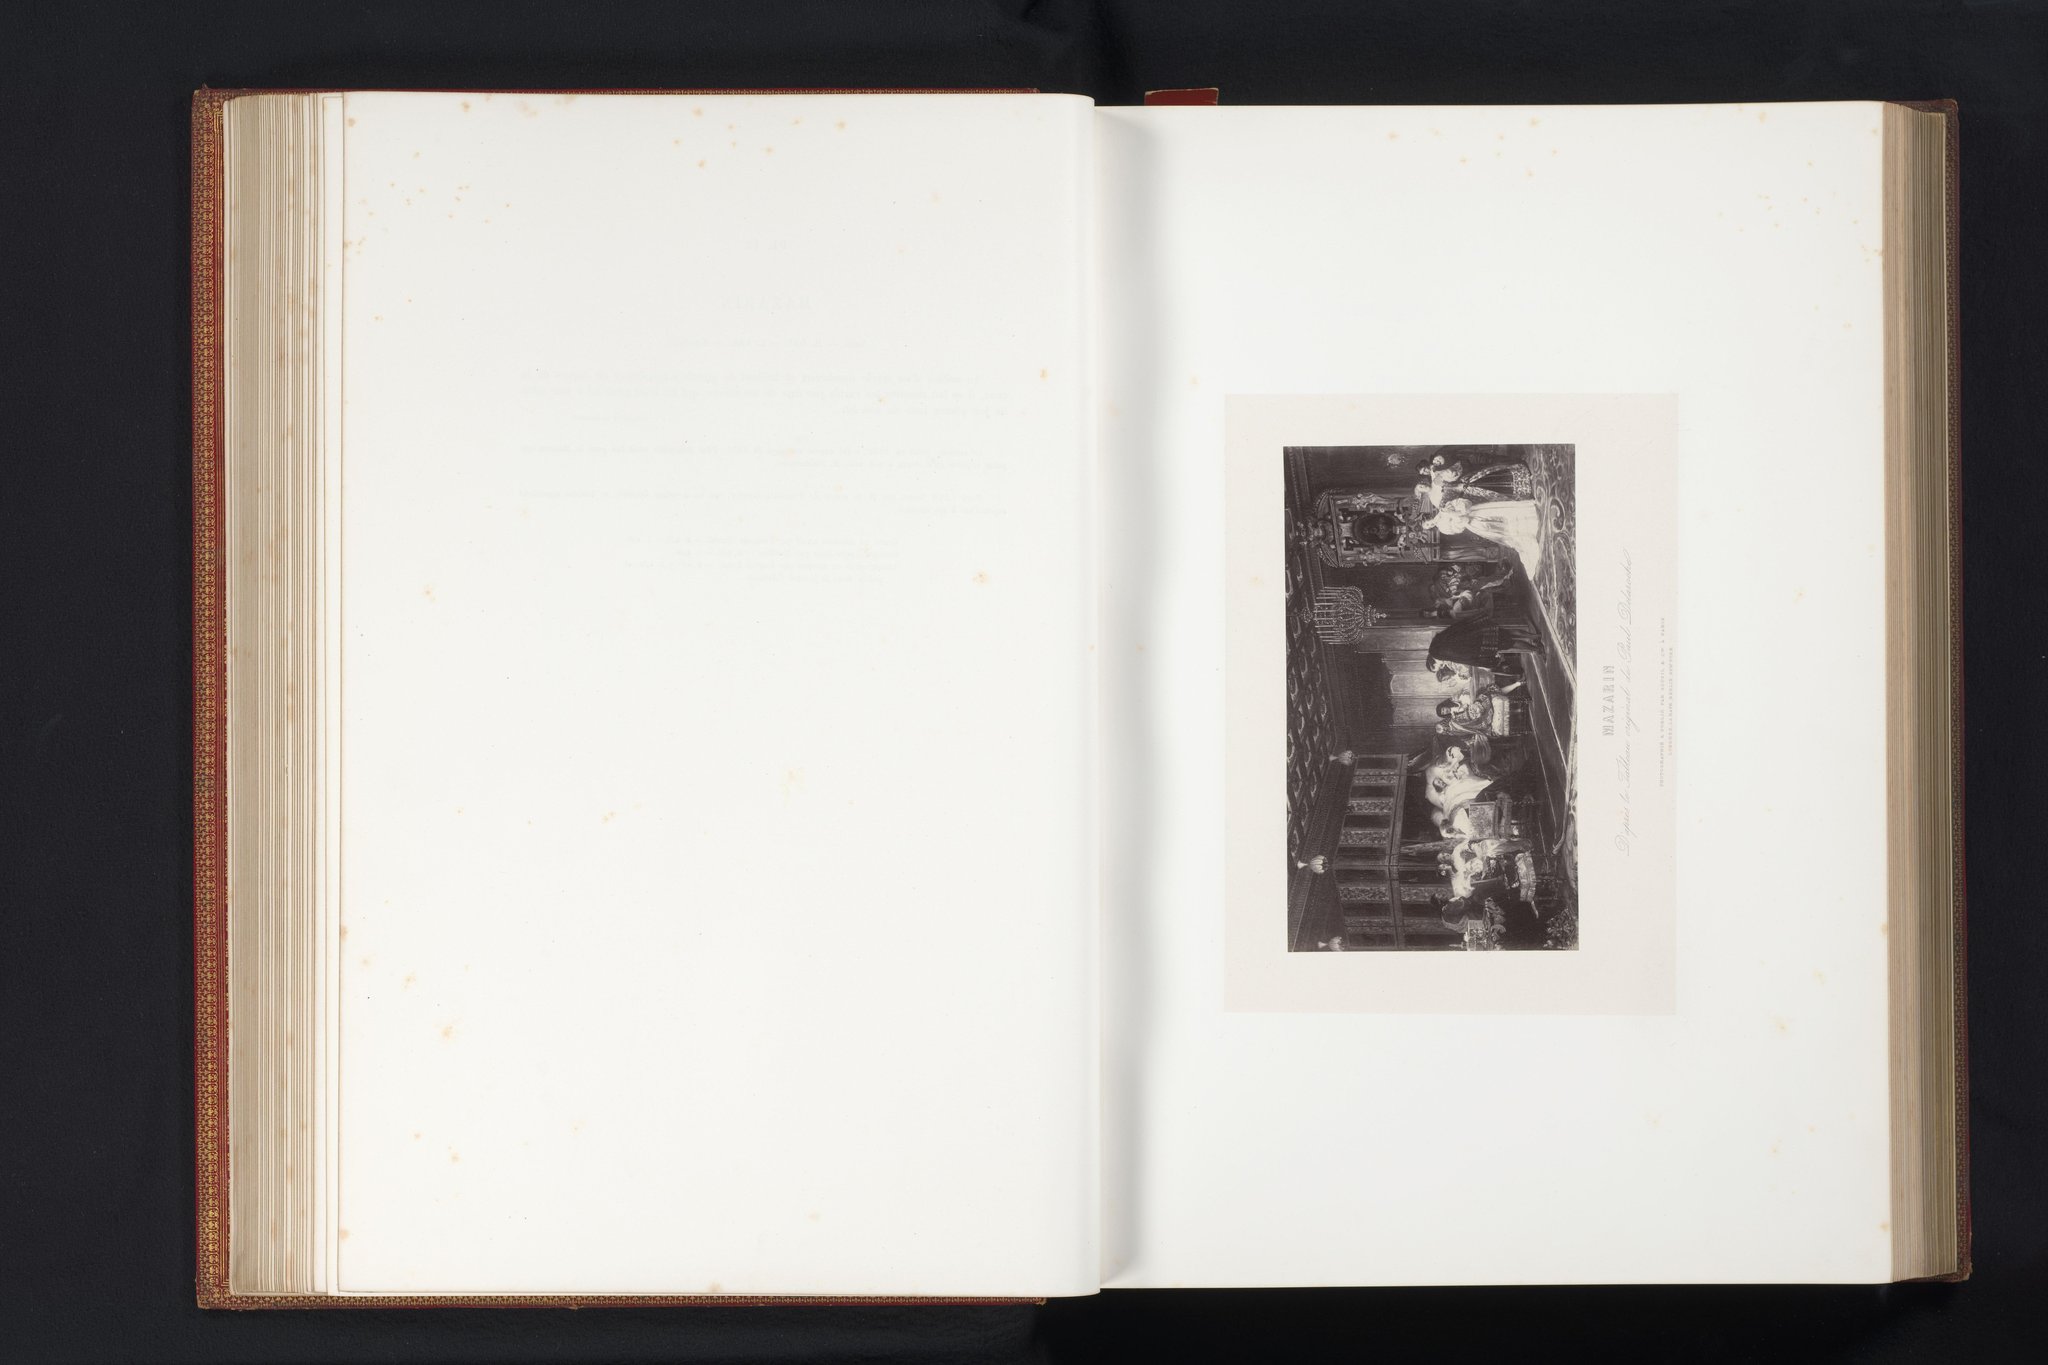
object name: page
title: Mazarin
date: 1853-1858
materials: paper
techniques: albumen print, engraving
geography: paris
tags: jules mazarin, family of a ruler, and court, daily life at court, resting, bedroom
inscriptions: check stamp: ‘Goupil & Cie’